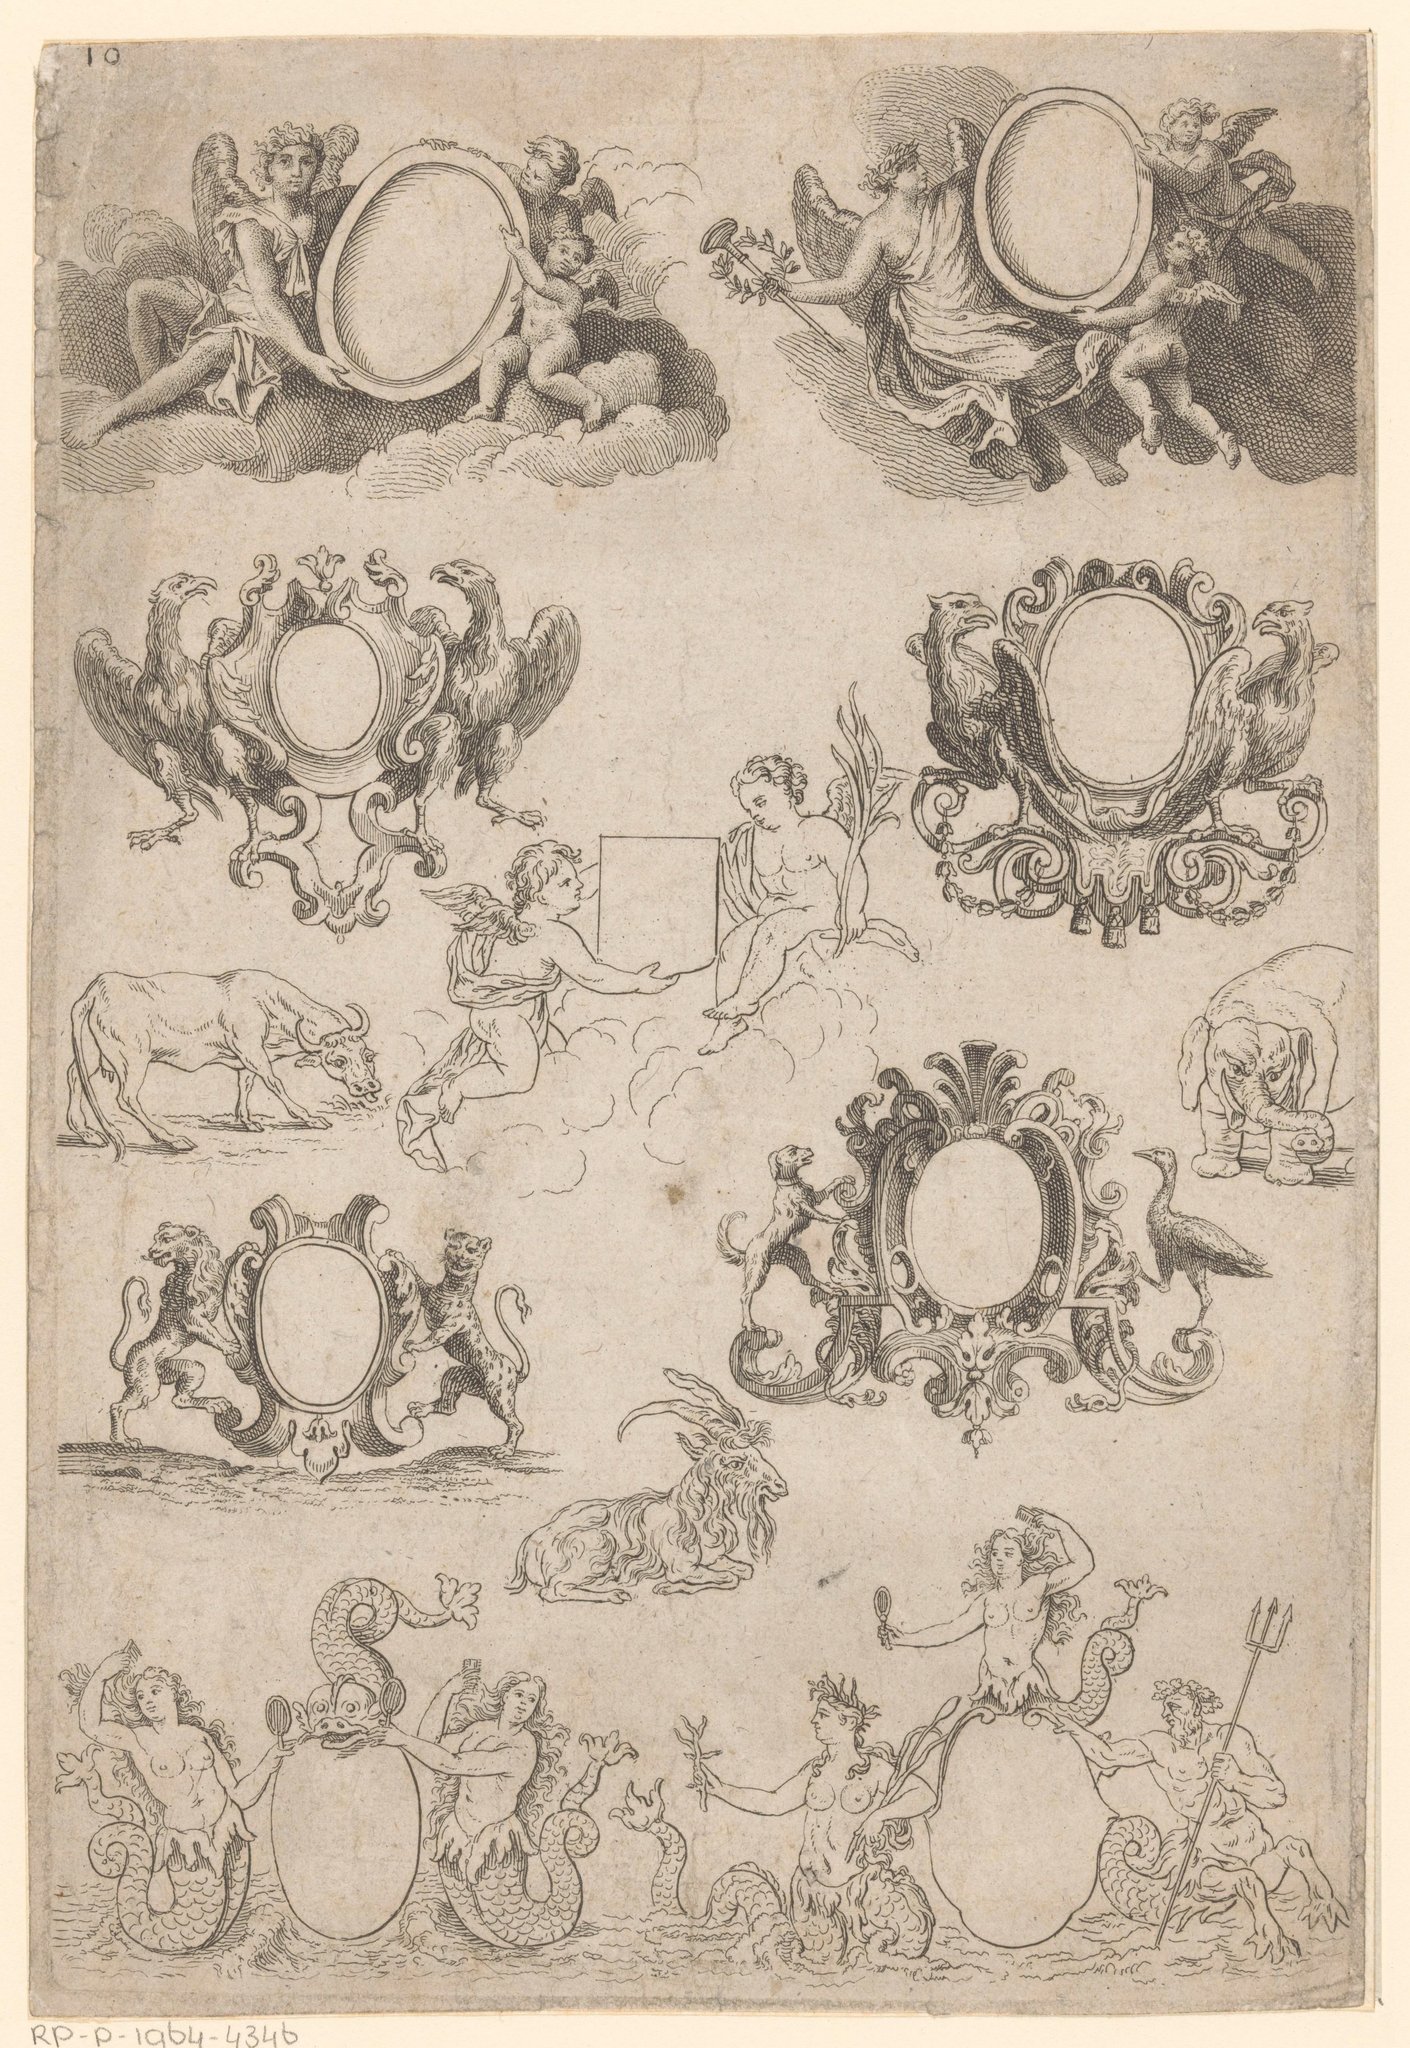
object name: print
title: Livre de Cartouches et supports d'Ornemens (...)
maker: nicolas guérard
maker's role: print maker, publisher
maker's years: 1648-1719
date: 1658-1719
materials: paper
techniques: etching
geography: paris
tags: animals, predatory birds: eagle, merman - aa - mermaid, siren, ornament ~ medallion, ornament ~ cartouche, angels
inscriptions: collector's mark: Lugt 2228, collector's mark: Lugt 2760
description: Vier medaillons vastgehouden door engelen en meerminnen en vier cartouches met adelaars en andere dieren aan weerszijden. In het midden een rund, twee engelen, een olifant en een bok.